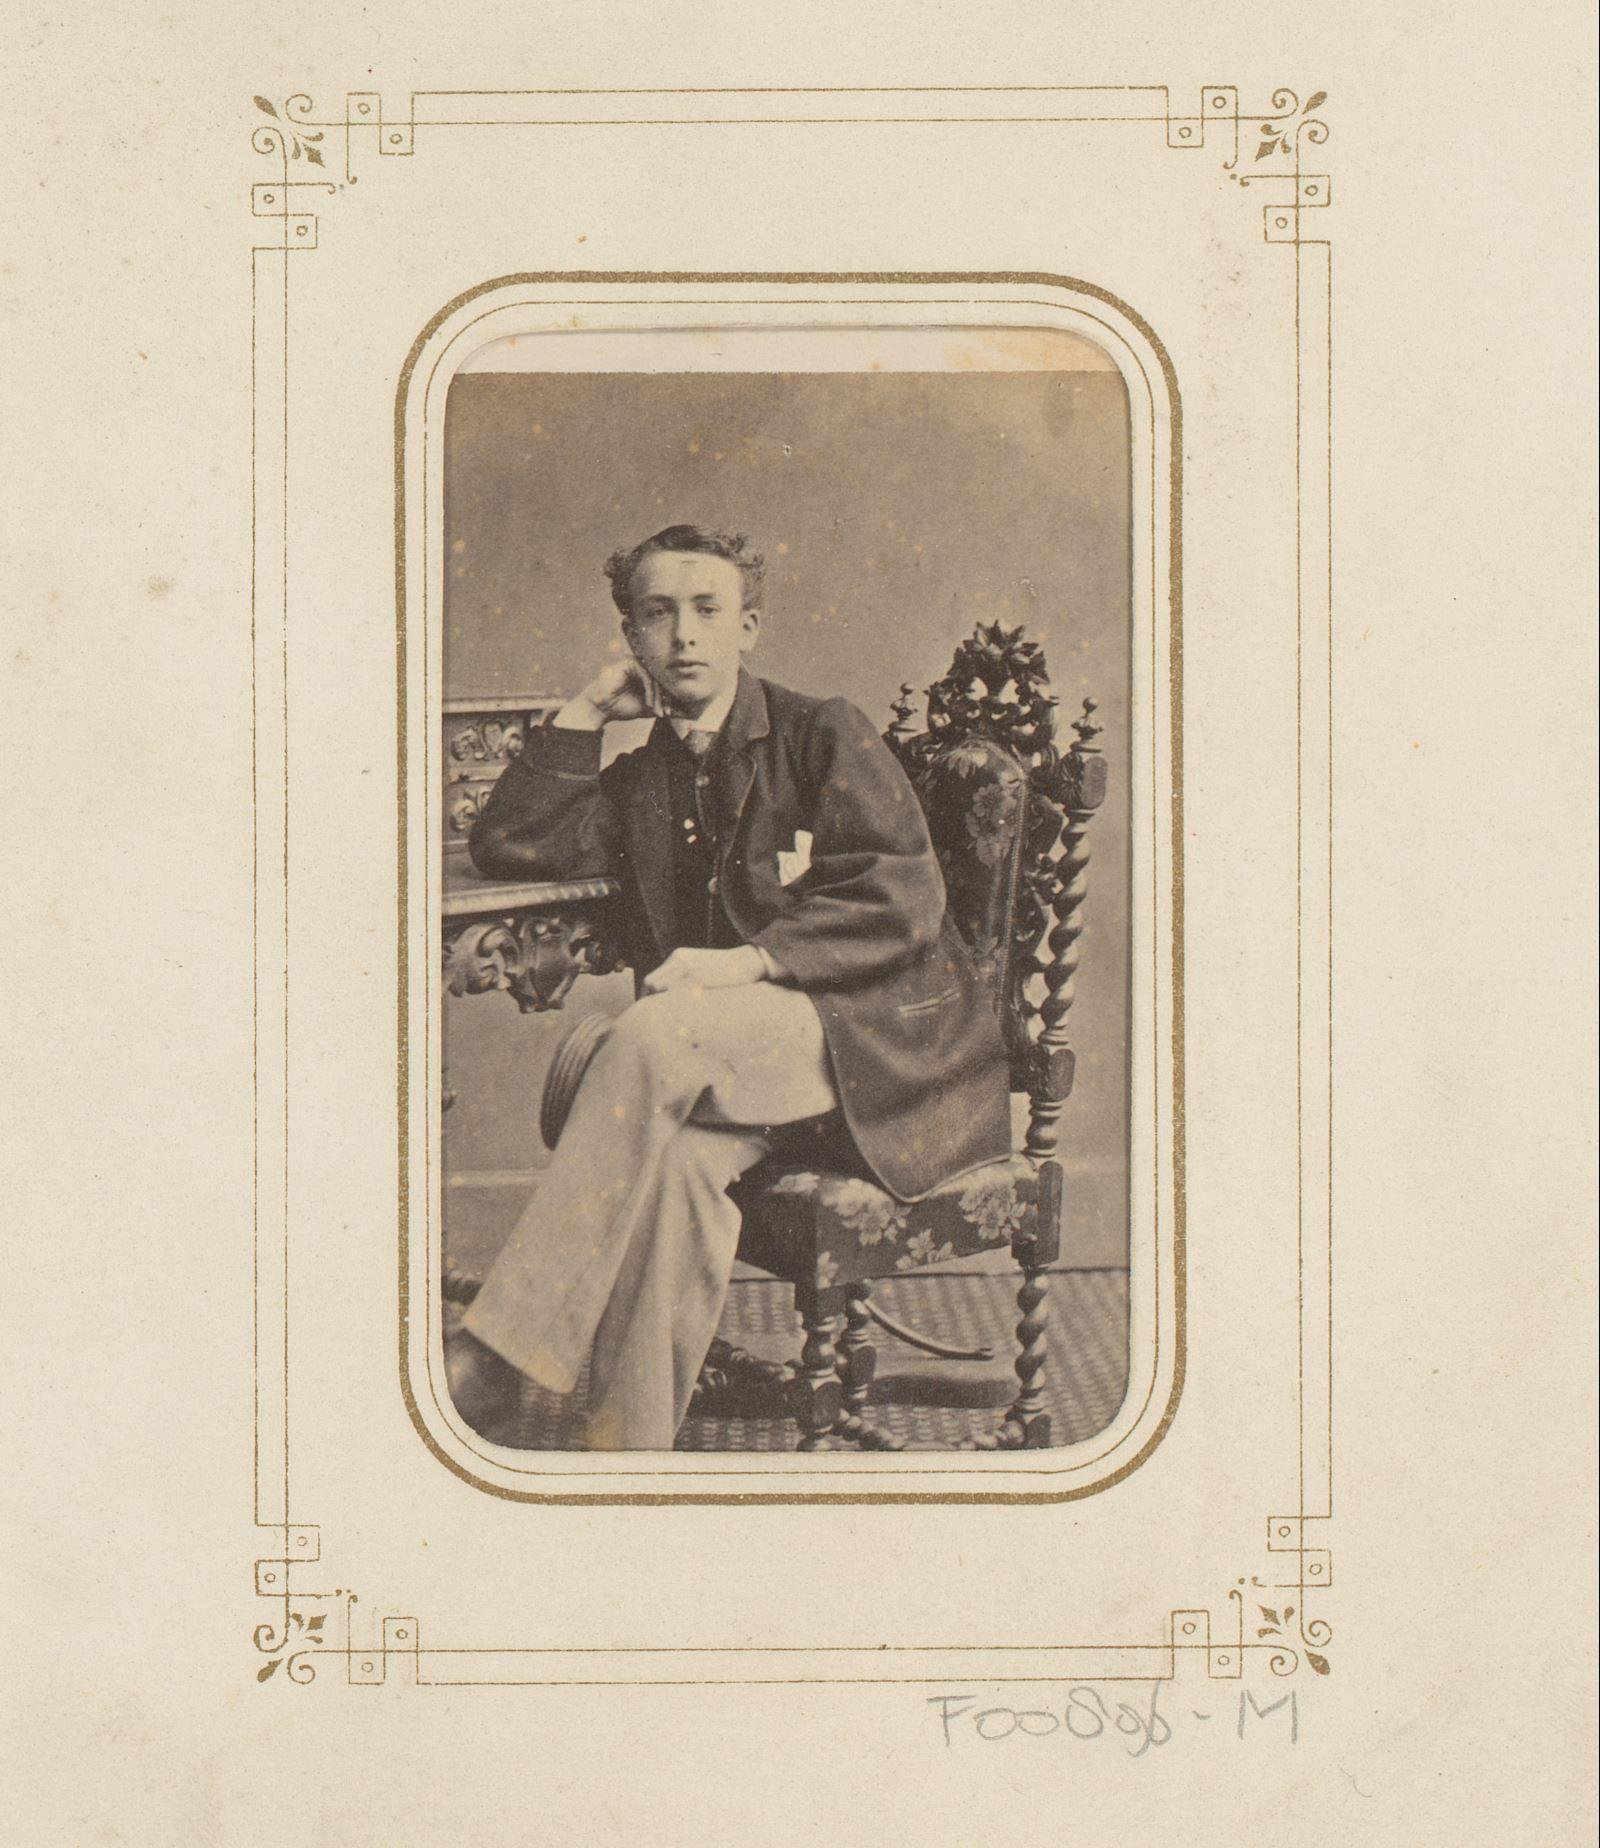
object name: album leaf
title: Portret van een zittende jongeman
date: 1864-1890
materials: cardboard, photographic support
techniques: albumen print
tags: sitting figure, adult man, historical persons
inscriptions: annotation: ‘[...]/ [...]1864/67’, inscription: ‘The London and continental/ Photographic/ copying company’